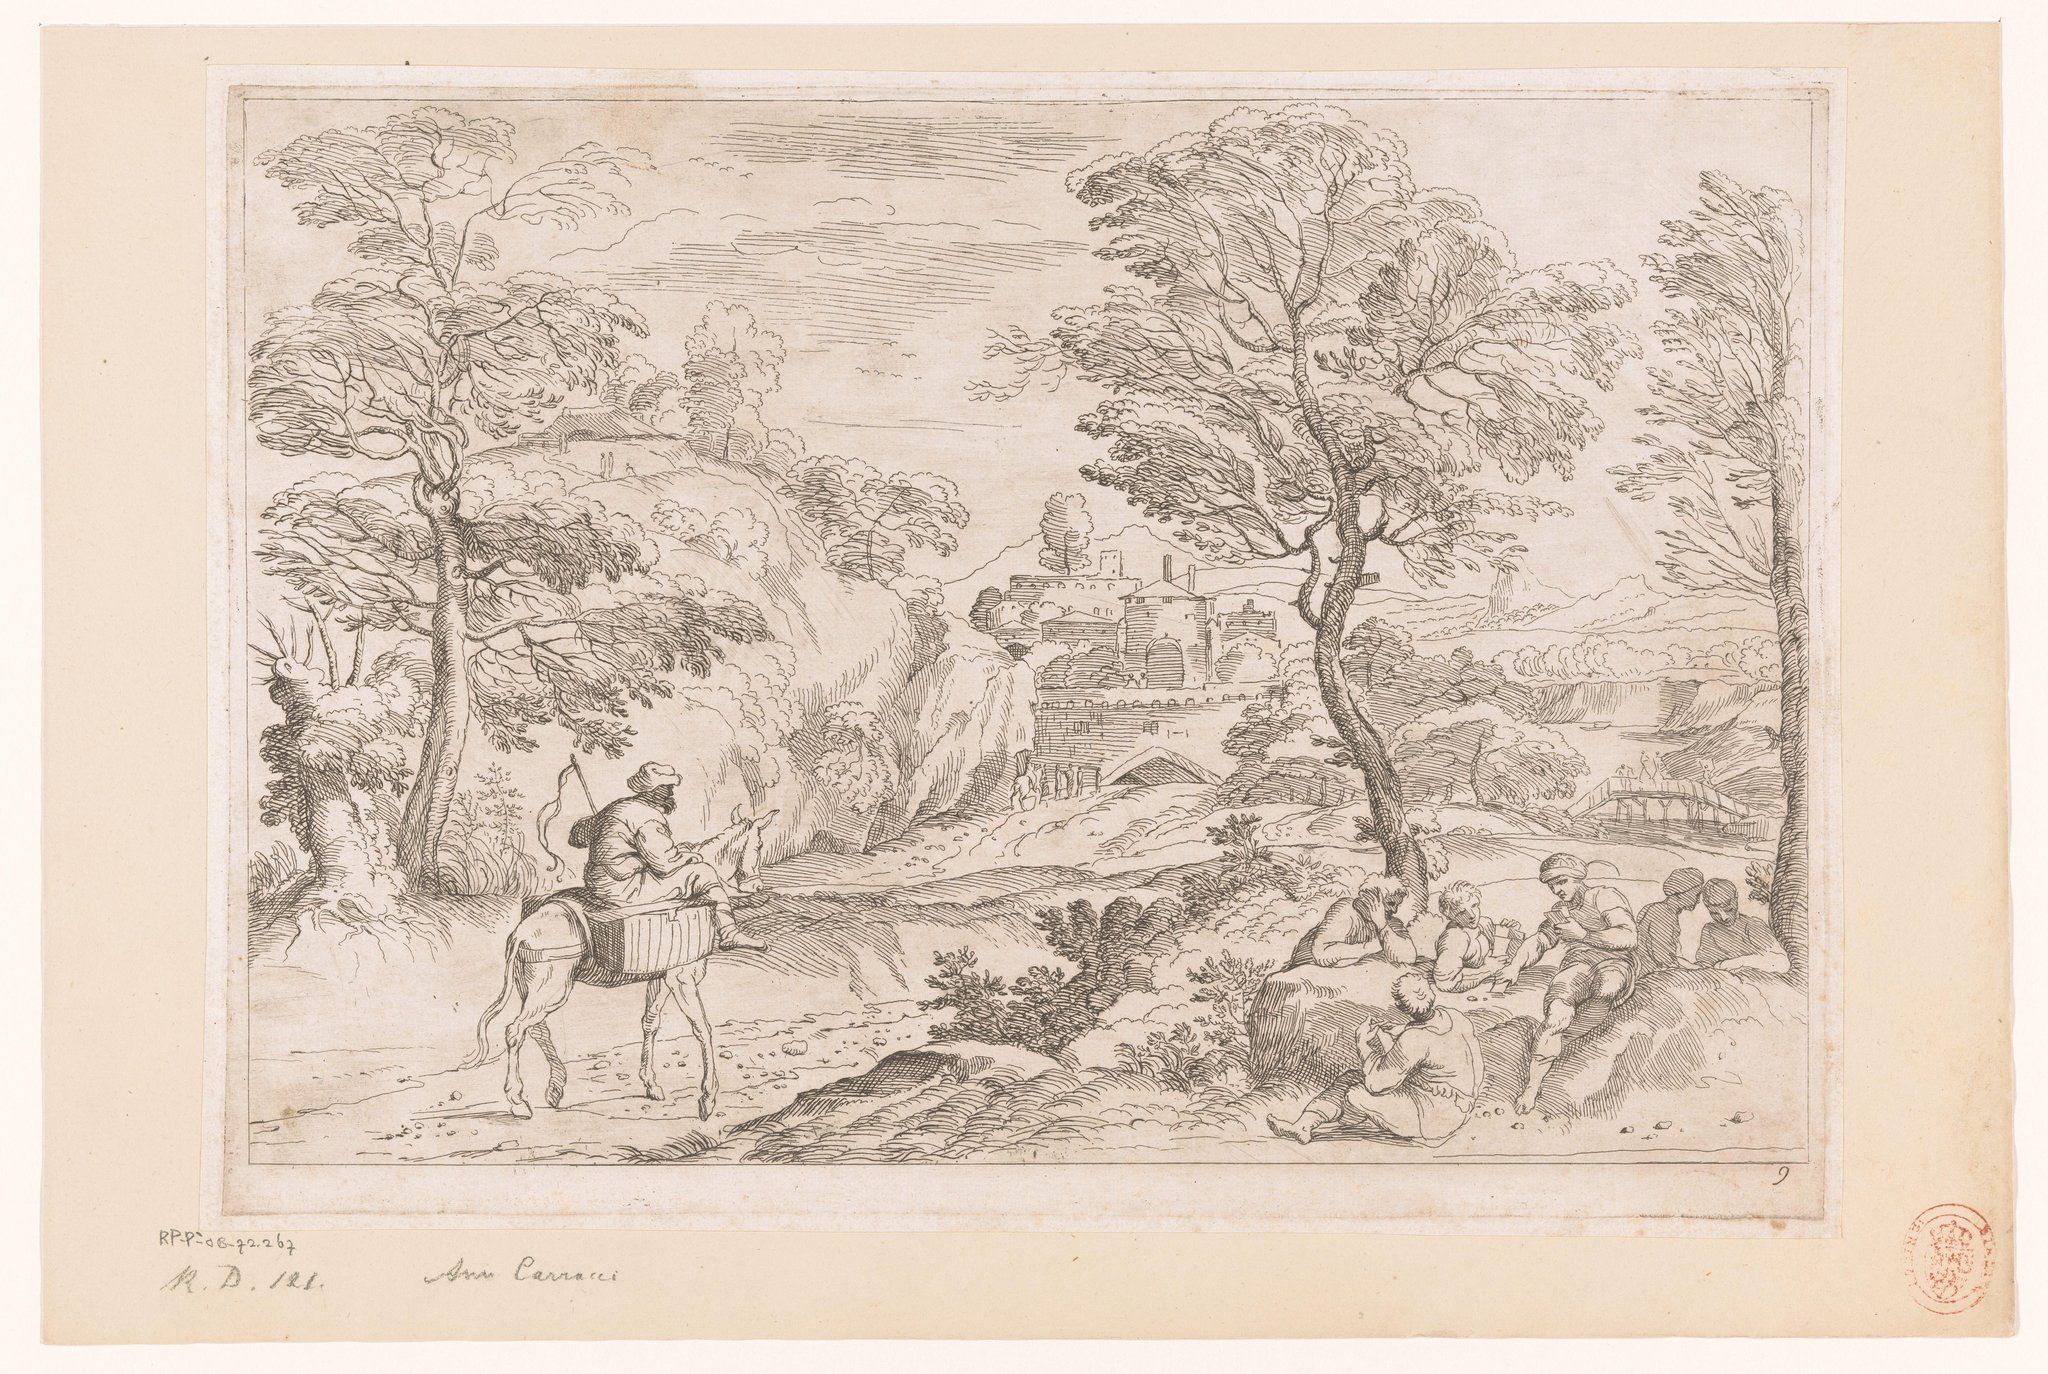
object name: print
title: Landschap met kaartspelende mannen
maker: jean pesne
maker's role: print maker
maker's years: 1623-1700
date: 1666-1695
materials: paper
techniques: etching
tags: landscapes, ass, donkey, card games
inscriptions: collector's mark: Lugt 240